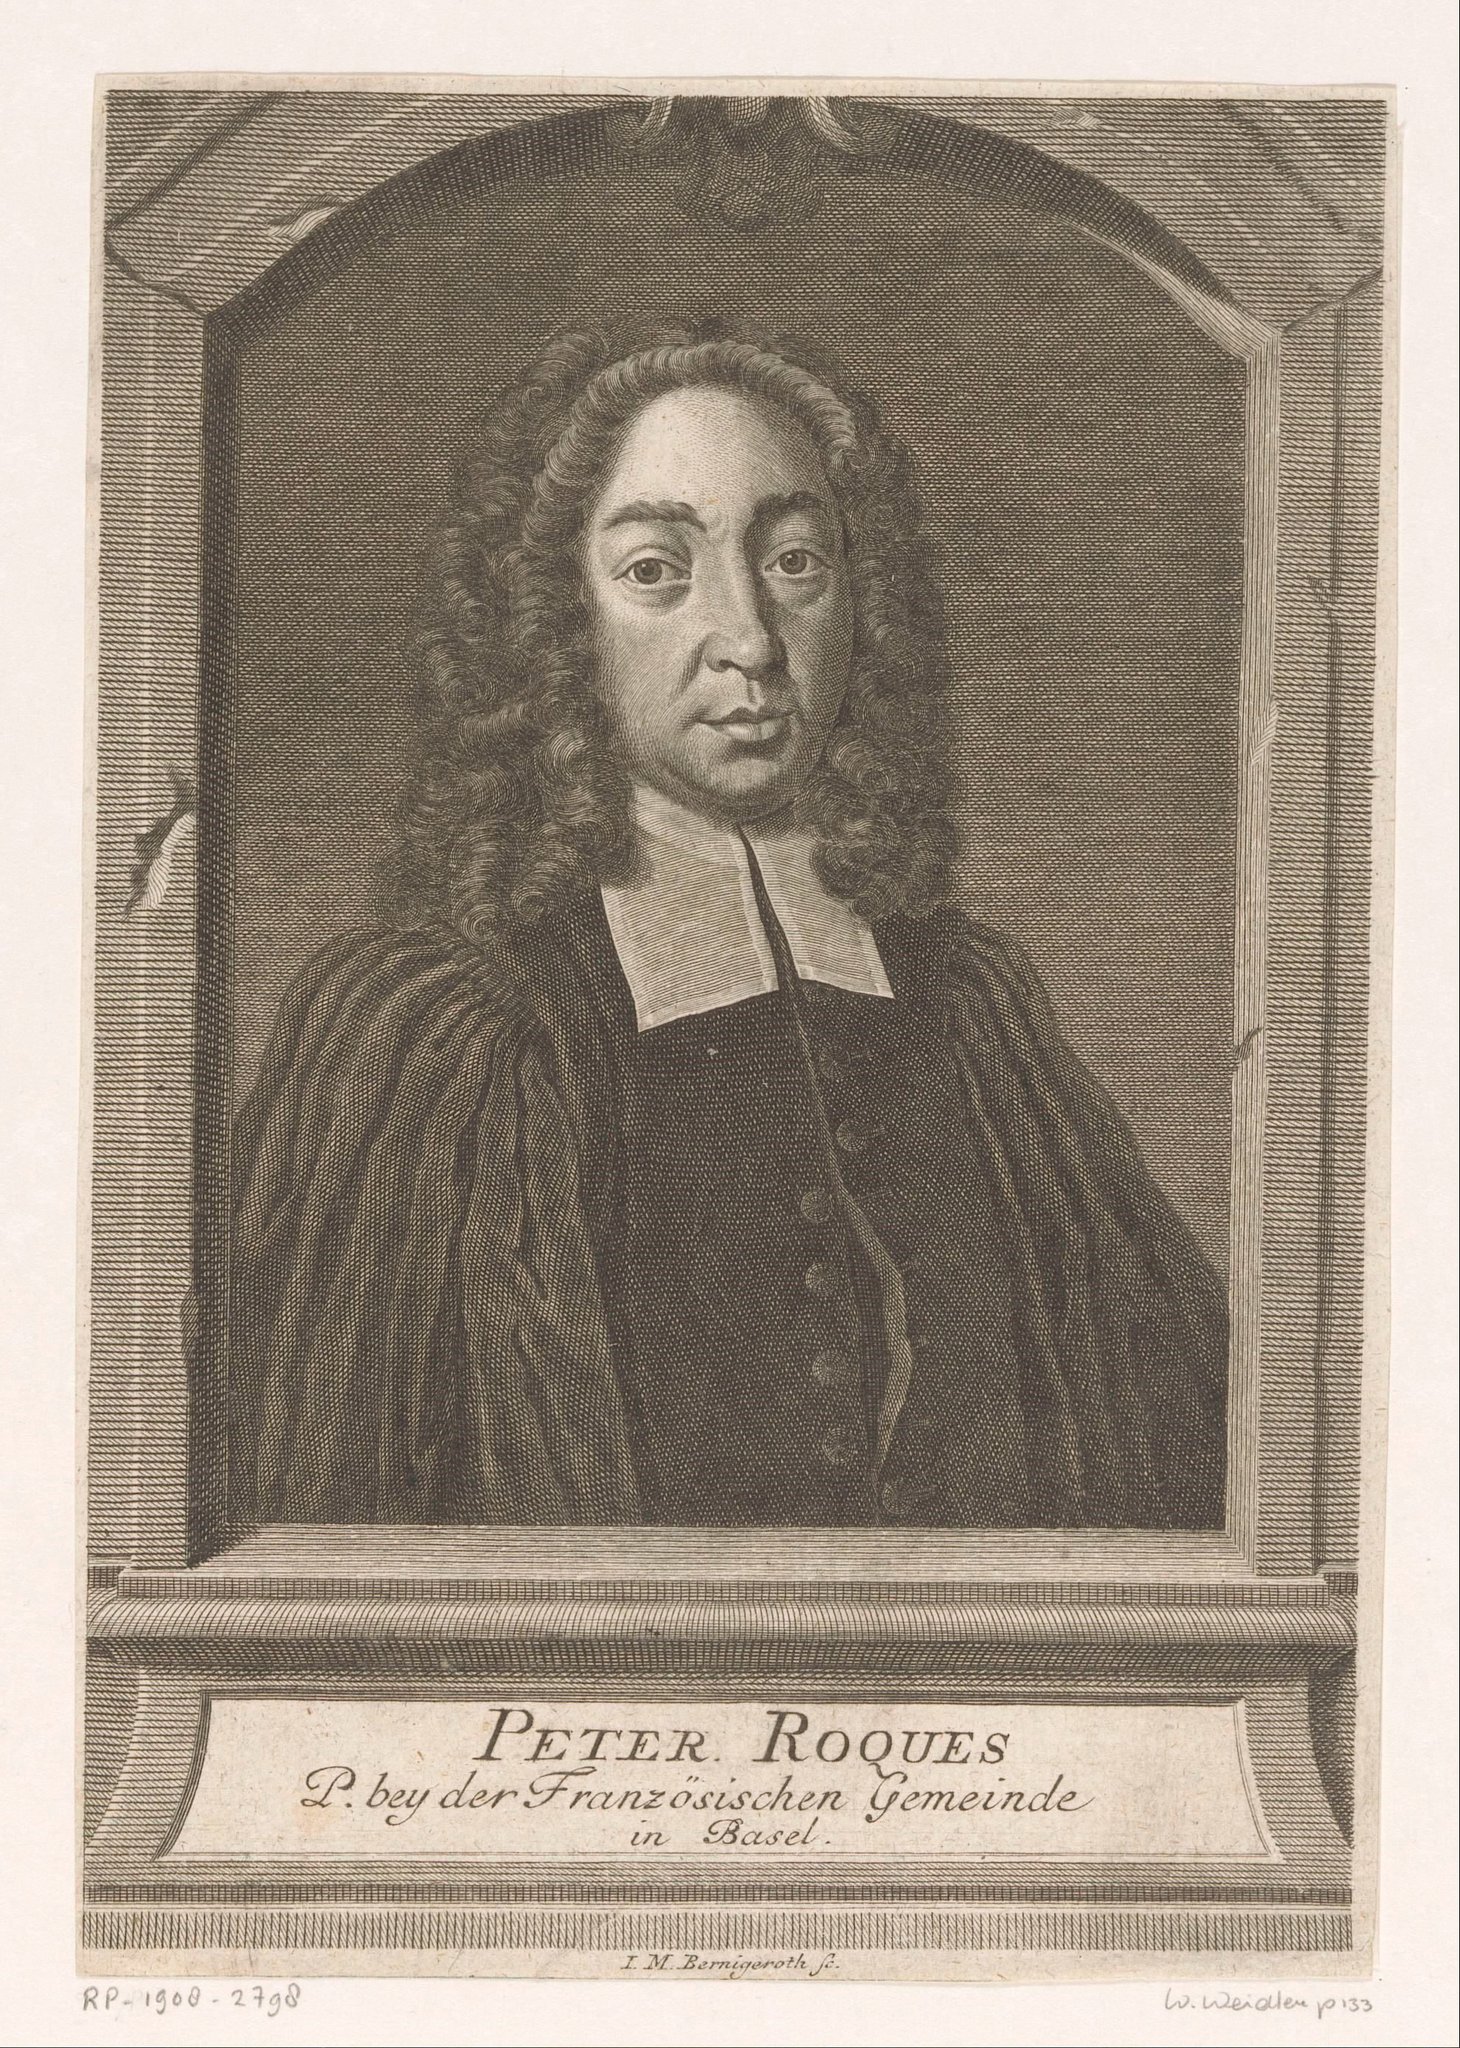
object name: print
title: Portret van Pierre Roques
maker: johann martin bernigeroth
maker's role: print maker, publisher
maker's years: 1713-1767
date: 1746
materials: paper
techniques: engraving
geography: leipzig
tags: historical persons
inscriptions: collector's mark: Lugt 2228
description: Prent ook gebruikt in: Saurin, Jacques. Betrachtungen über die Wichtigsten Begebenheiten des Alten und Neuen Testament. Fortgesetzet von Herrn Peter Roques, Pastor bey der Französischen Gemeinde in Basel. Rostock: Johann Christian Koppe, 1746.